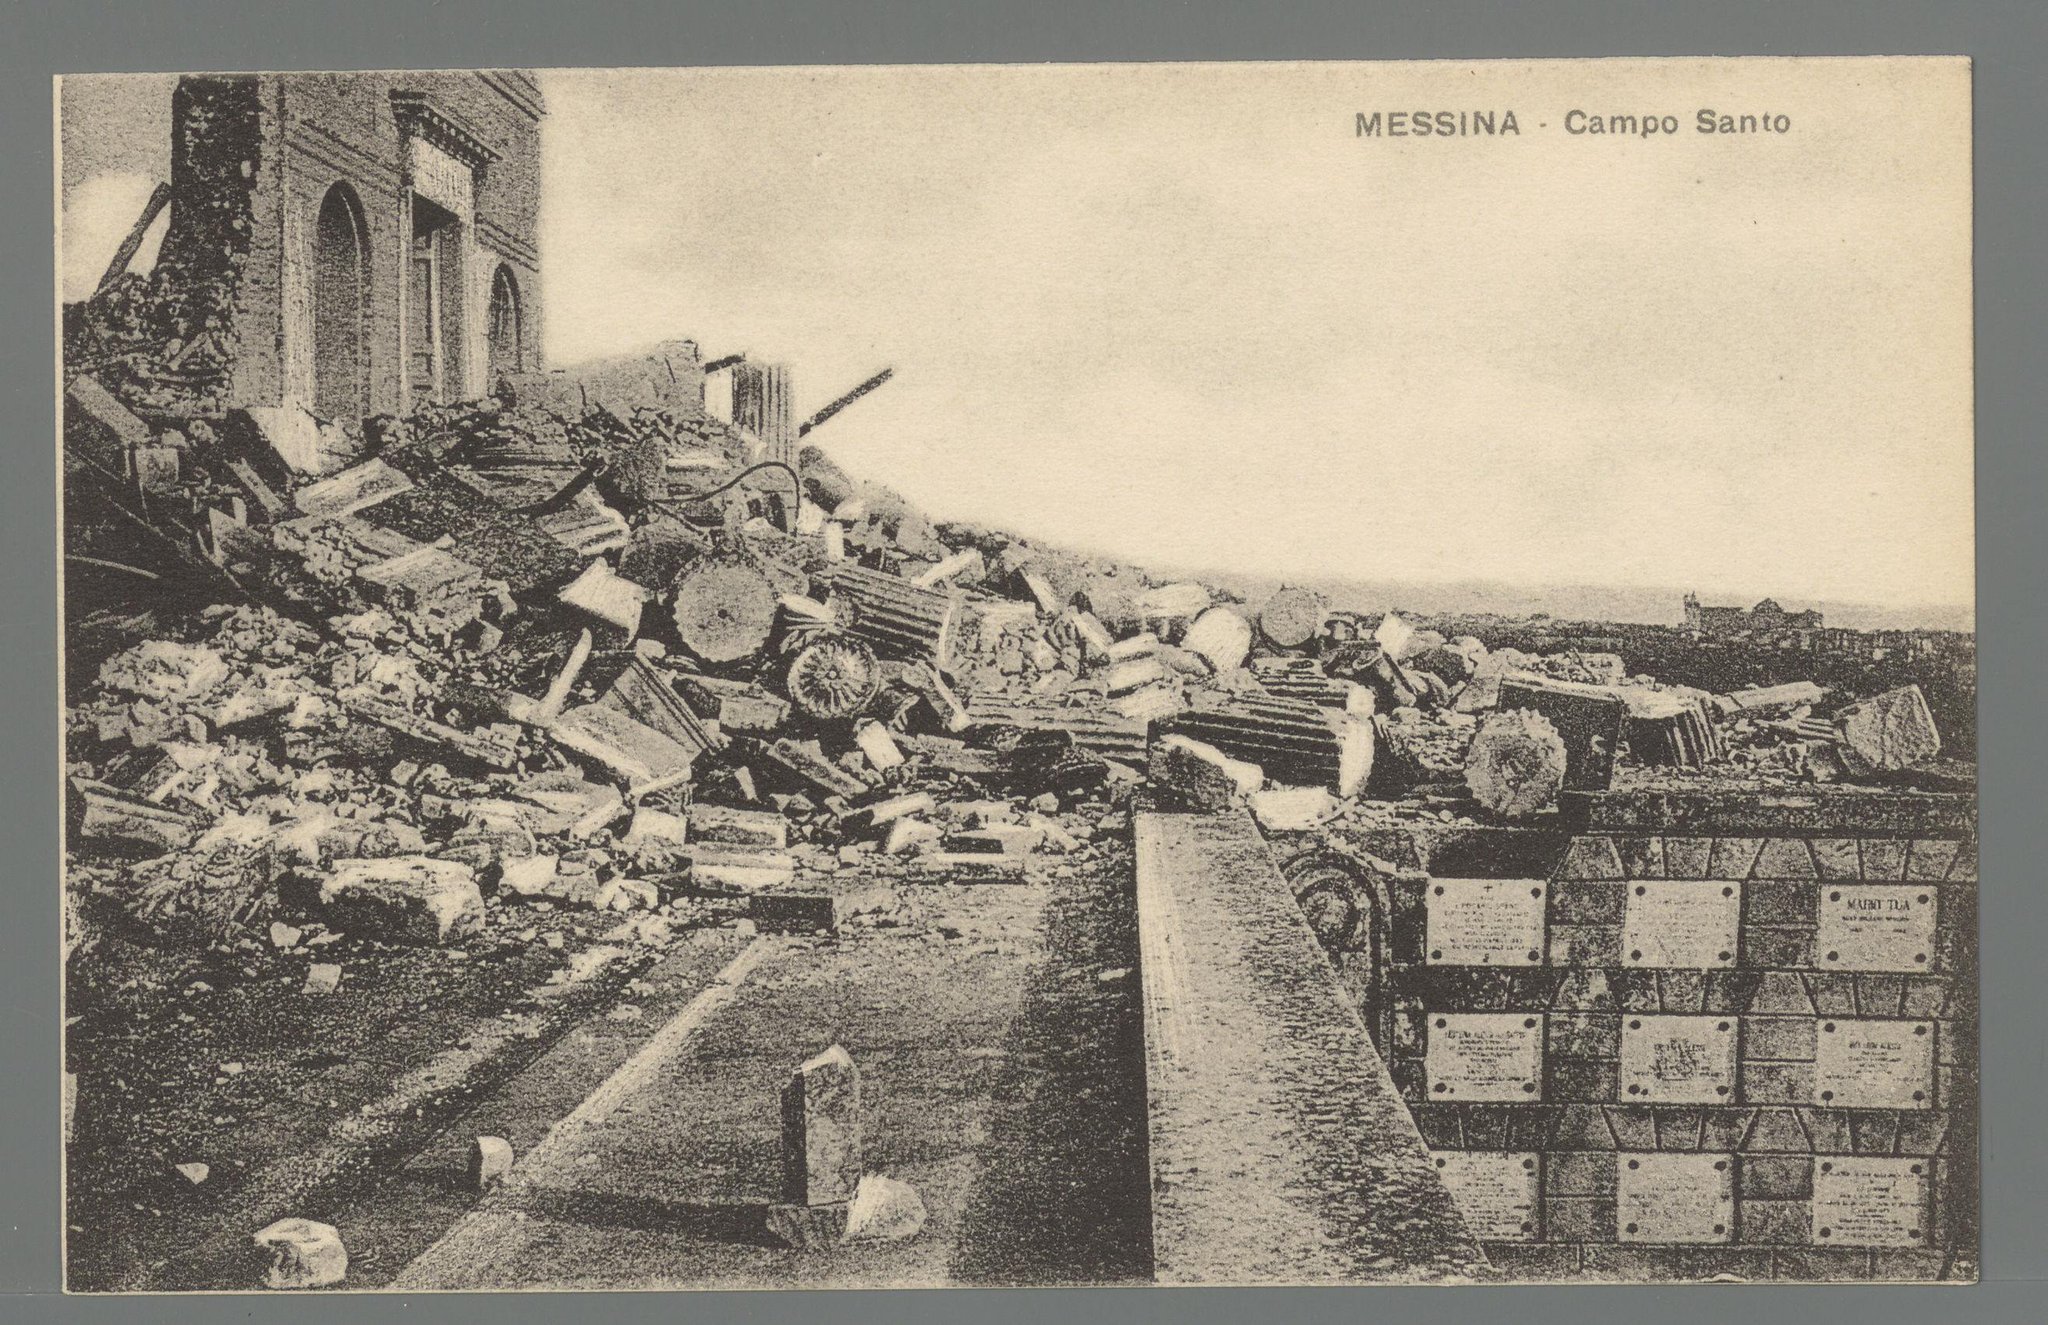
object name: photomechanical print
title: Messina. Campo Santo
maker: Anonymous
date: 1908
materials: cardboard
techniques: photograph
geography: messina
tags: consequences of an earthquake, collapsing building, cemetery, park-like burying ground